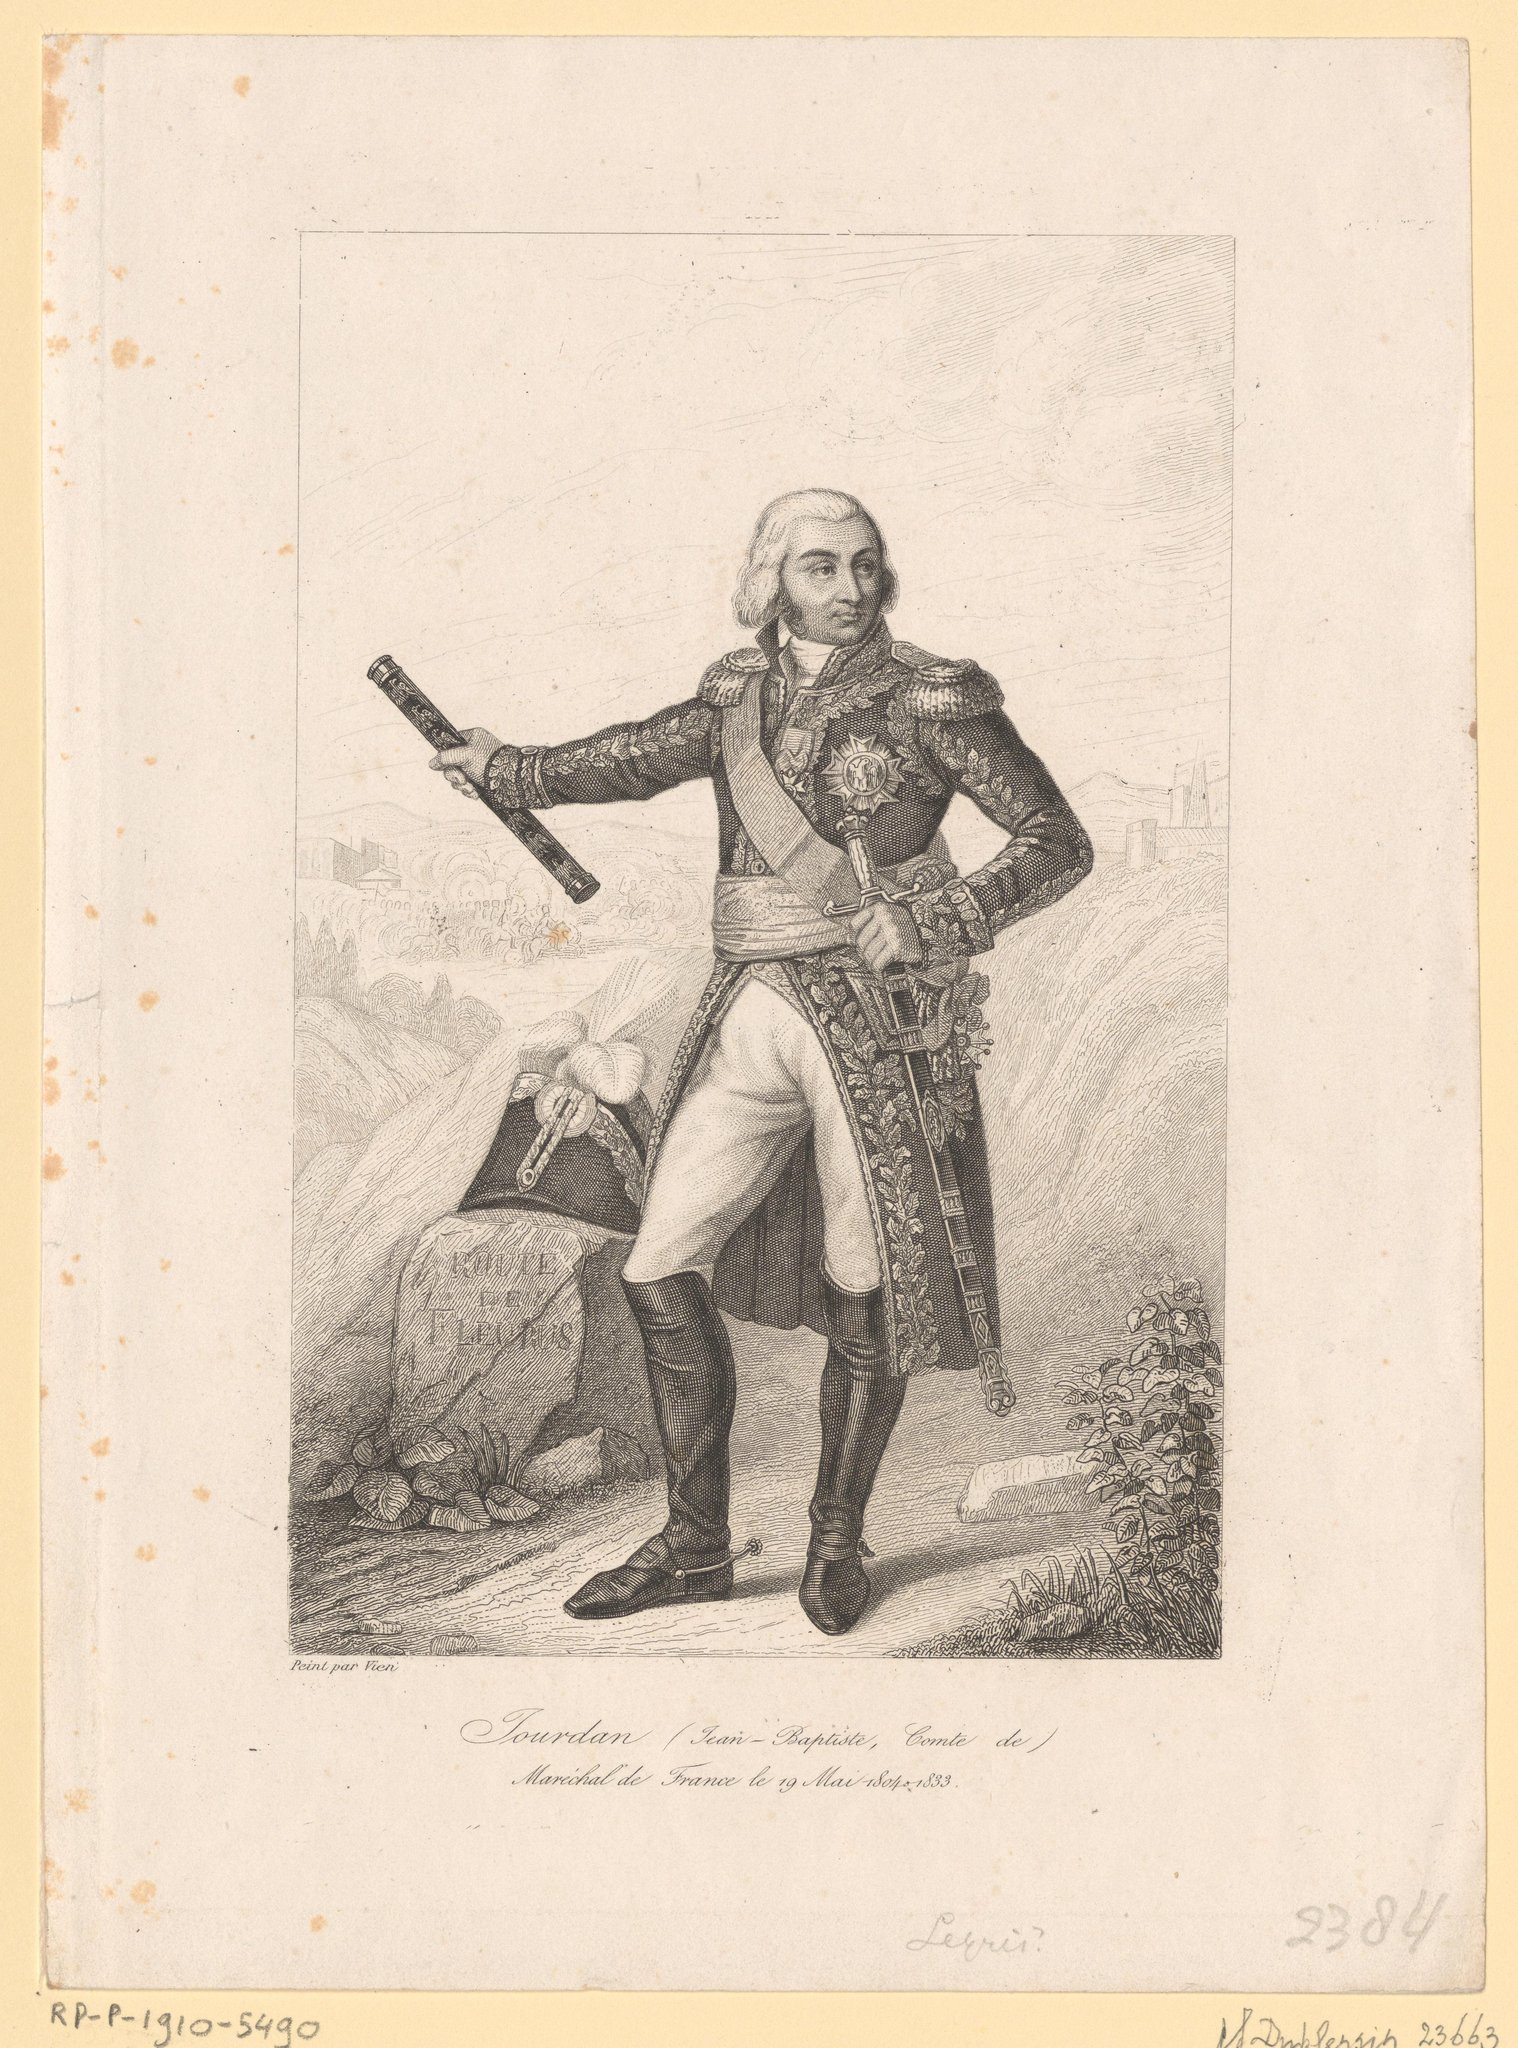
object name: print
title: Galeries de Versailles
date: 1850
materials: paper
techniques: etching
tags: paris, politician, commander-in-chief, general, marshal, historical persons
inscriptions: collector's mark: Lugt 2228